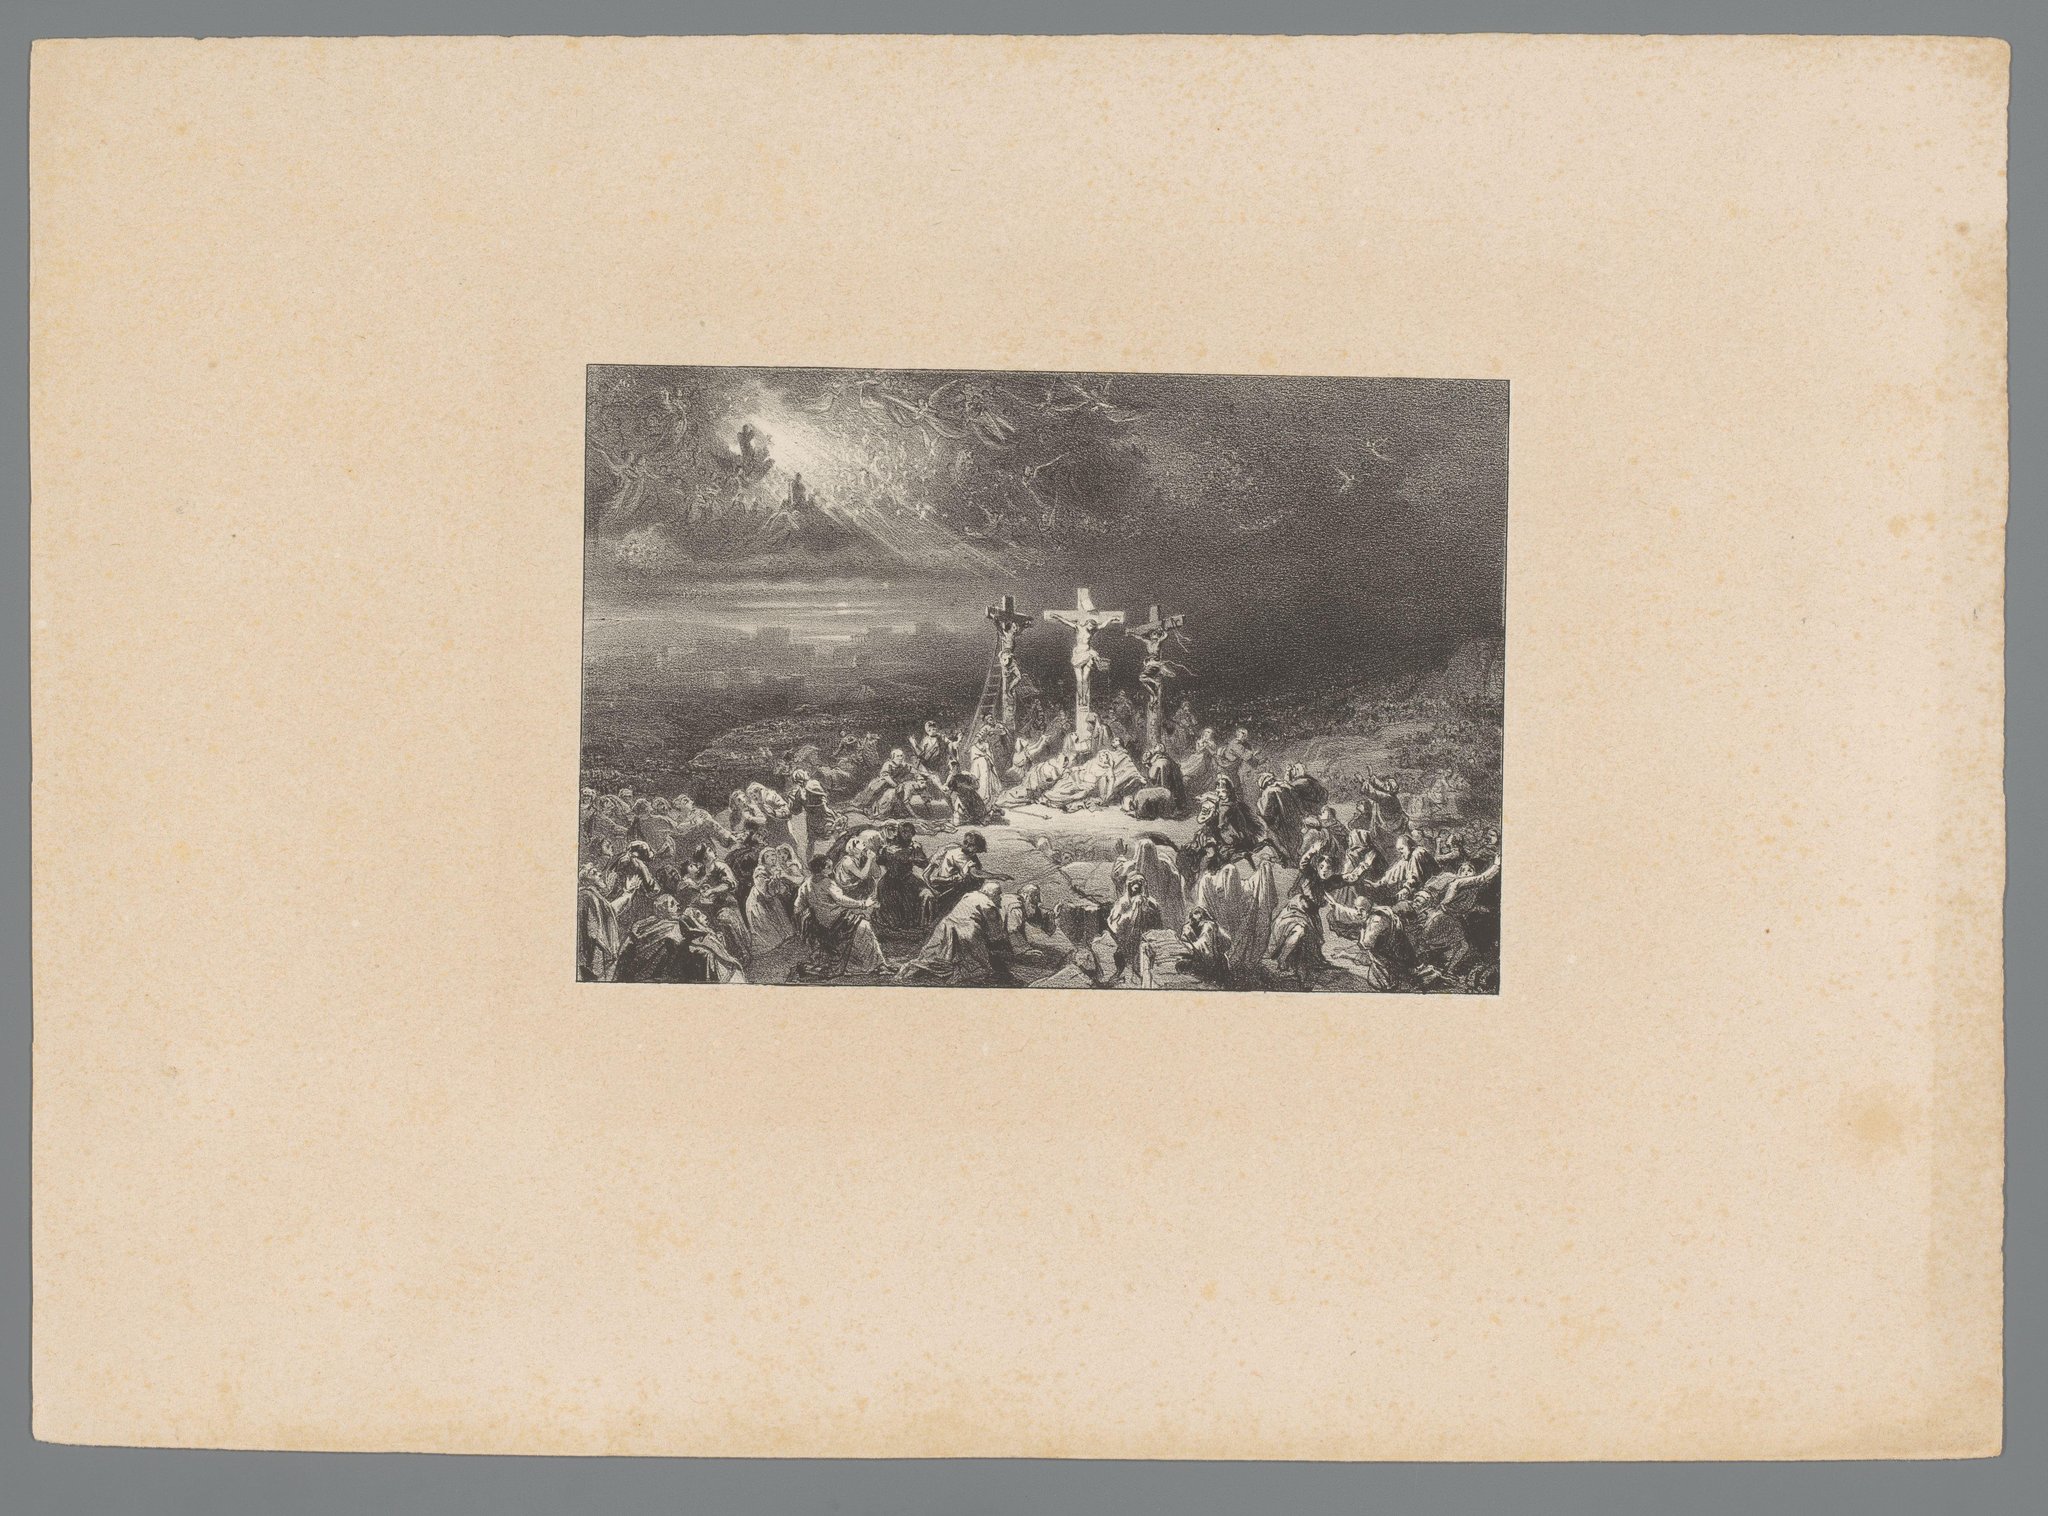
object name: print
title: Dernier soupir de Christ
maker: adolphe mouilleron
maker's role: draughtsman, print maker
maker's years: 1820-1881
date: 1840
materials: paper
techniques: lithograph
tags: the crucifixion of christ: christ's death on the cross; golgotha (matthew 27:45-58; mark 15:33-45; luke 23:44-52; john 19:25-38)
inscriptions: collector's mark: Lugt 964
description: Latere staat van prent verschenen in: Robert, Jules. Album du Salon de 1840. Collection des principaux ouvrages exposés au Louvre (…). Parijs: Challamel & Cie, 1840.